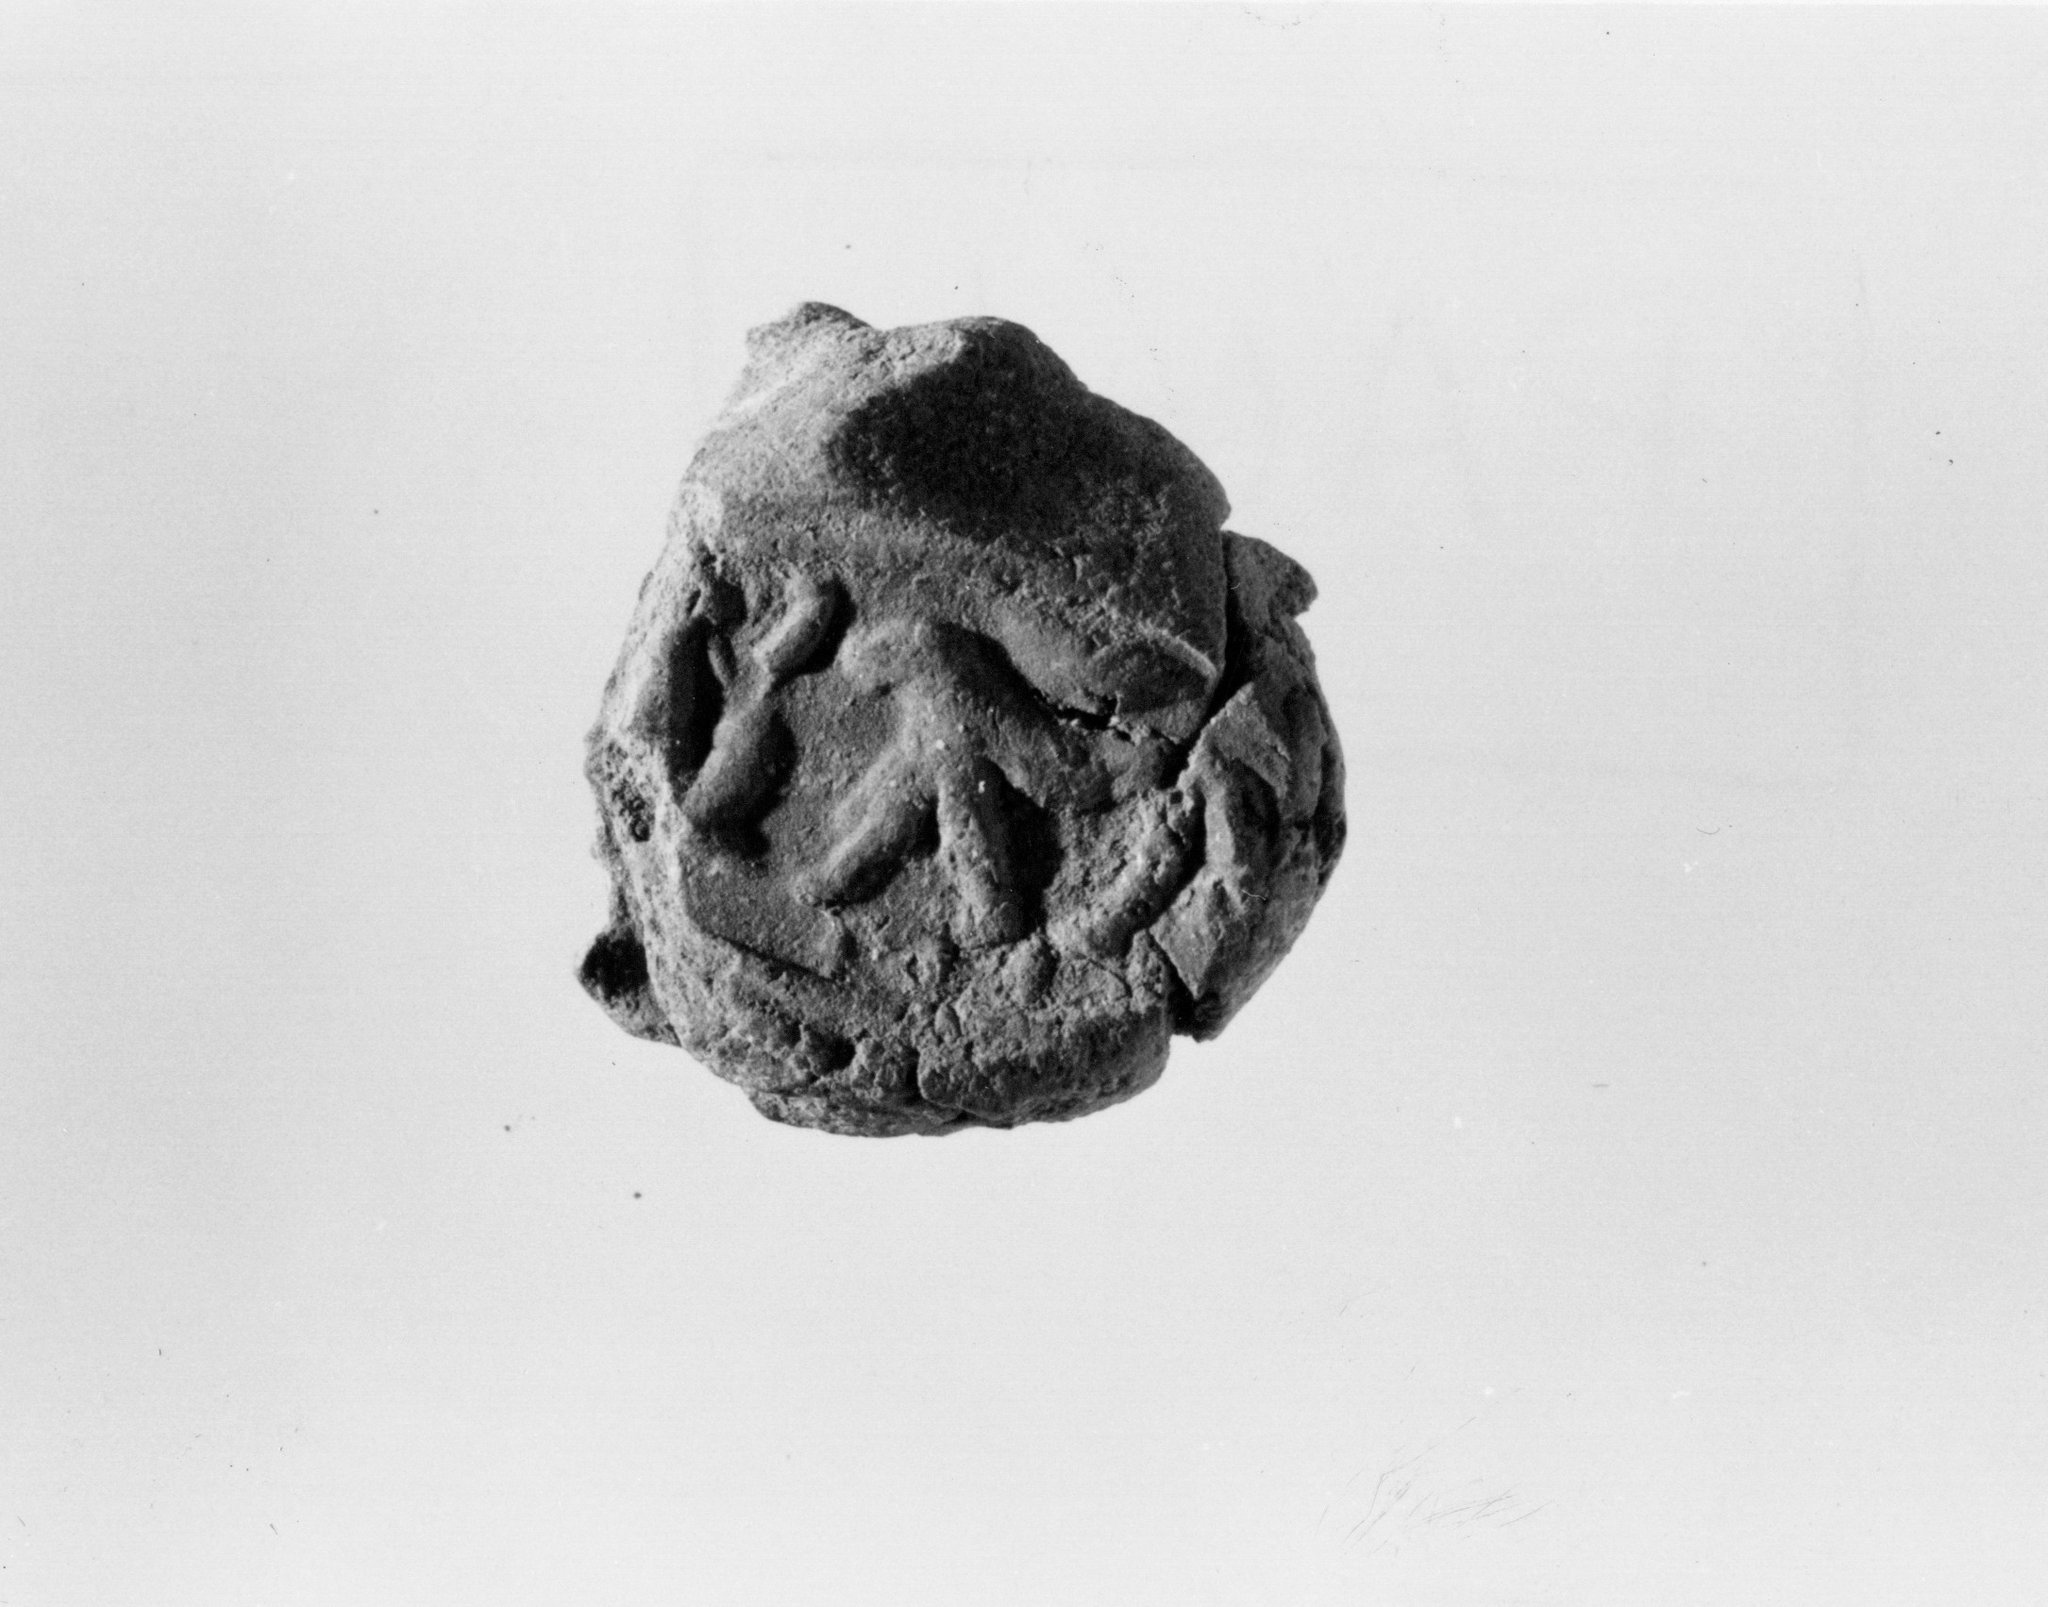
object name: sealing, nebmaatre, amenhotep iii, lion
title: Document Sealing With the Throne Name of Amenhotep III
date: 1390-1352 BCE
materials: mud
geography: egypt